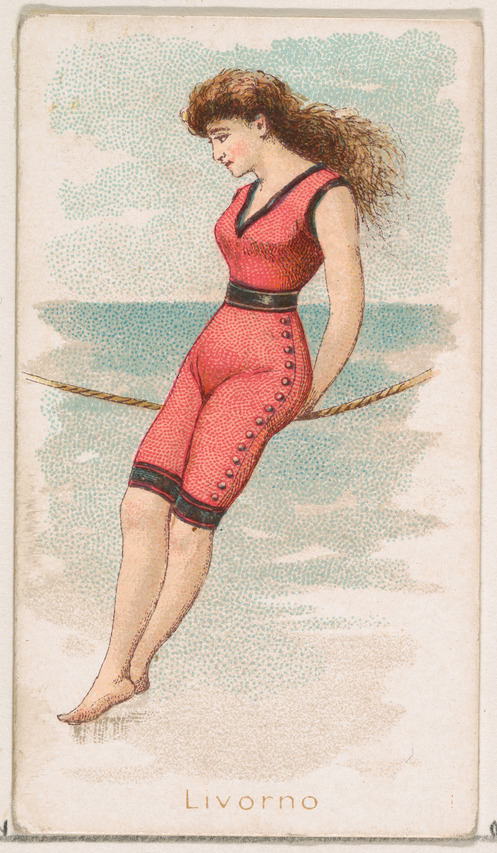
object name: print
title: Livorno, from the Fancy Bathers series (N187) issued by Wm. S. Kimball & Co.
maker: william s. kimball & company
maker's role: publisher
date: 1889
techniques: color lithograph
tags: profiles,women